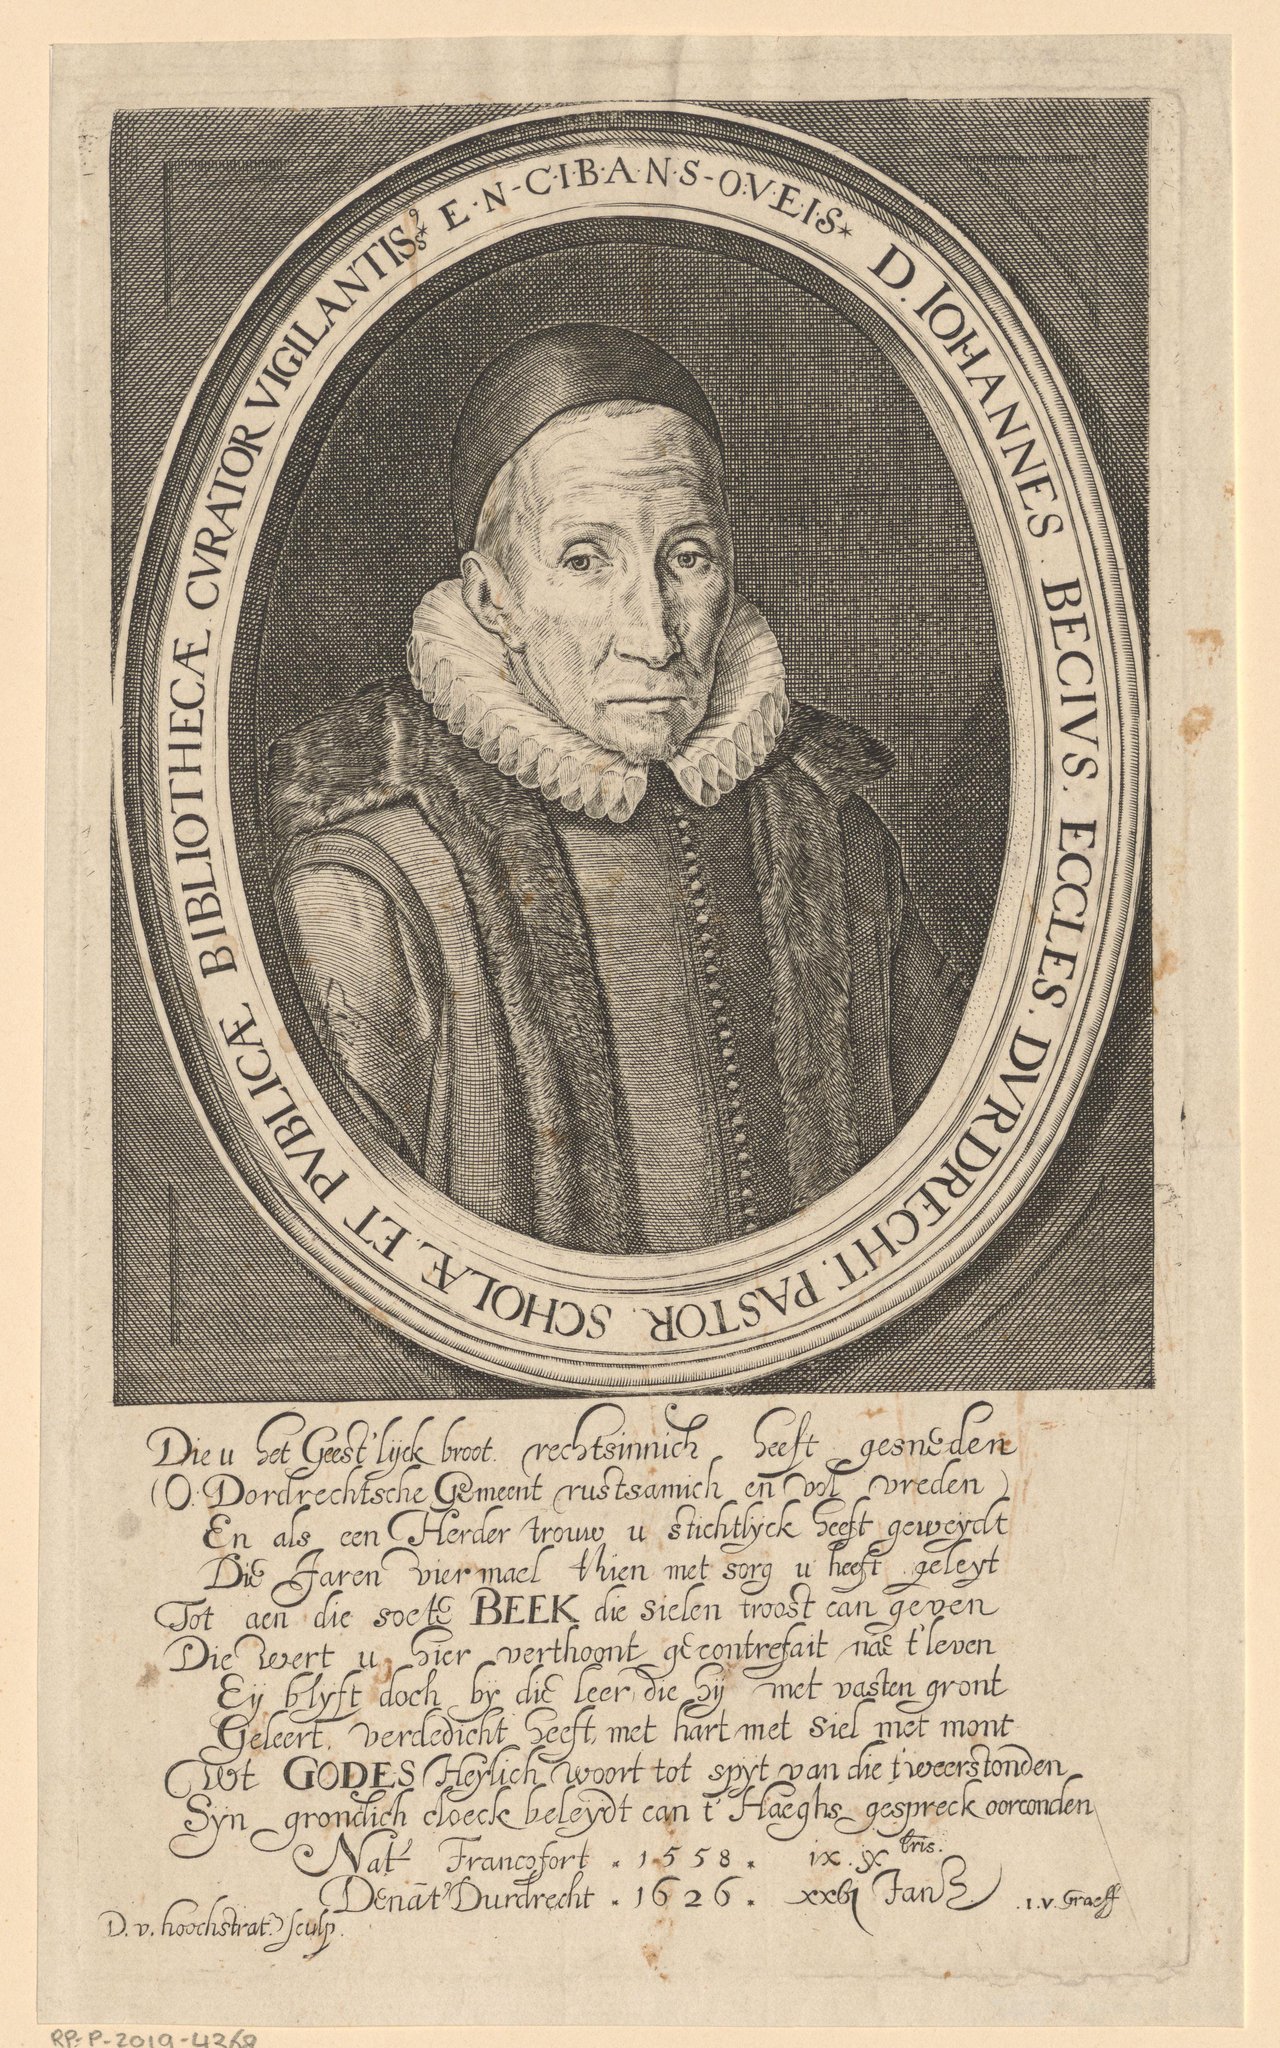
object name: print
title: Portret van Johannes Becius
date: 1626-1640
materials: paper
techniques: engraving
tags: dordrecht, historical persons